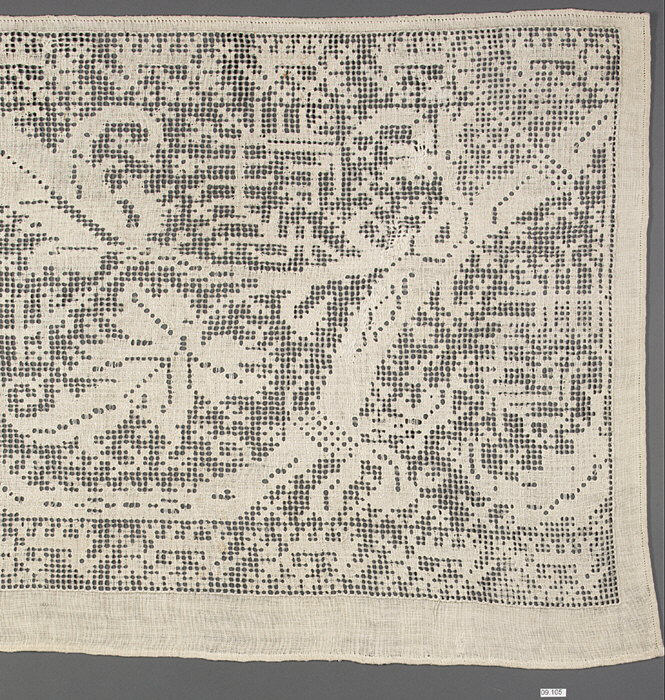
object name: border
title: Border (in two pieces)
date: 1601-1633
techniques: embroidery